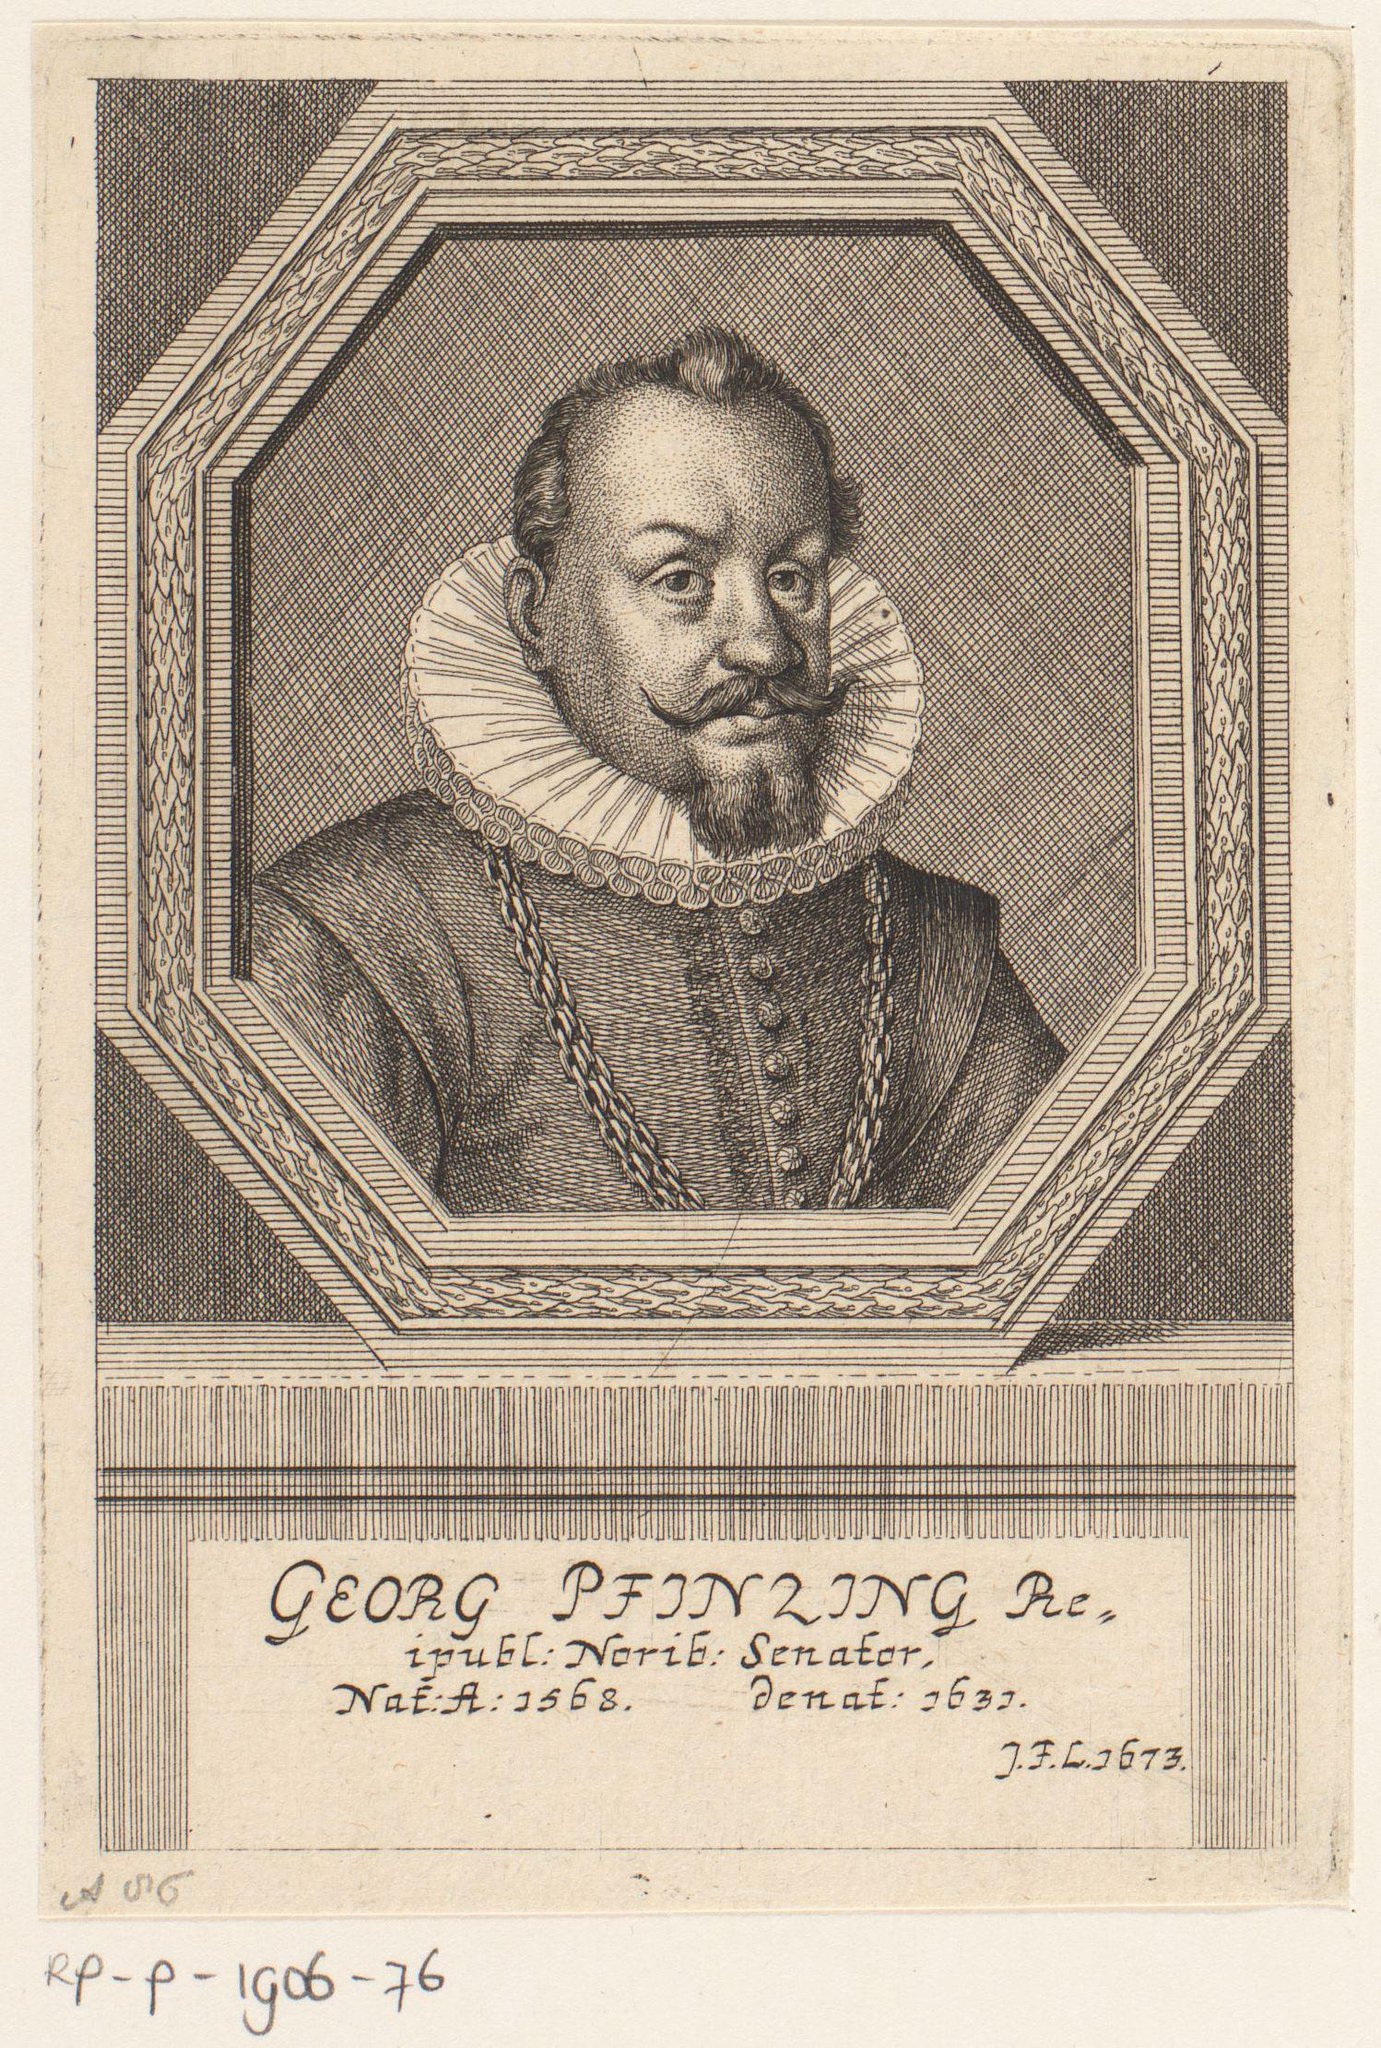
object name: print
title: Portret van Georg Pfintzing von Hefenfeld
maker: johann friedrich leonard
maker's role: print maker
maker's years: 1633-1680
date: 1673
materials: paper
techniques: engraving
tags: senator, georg pfintzing von hefenfeld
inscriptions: collector's mark: Lugt 2228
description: Portret van Georg Pfintzing von Hefenfeld, senator te Neurenberg.